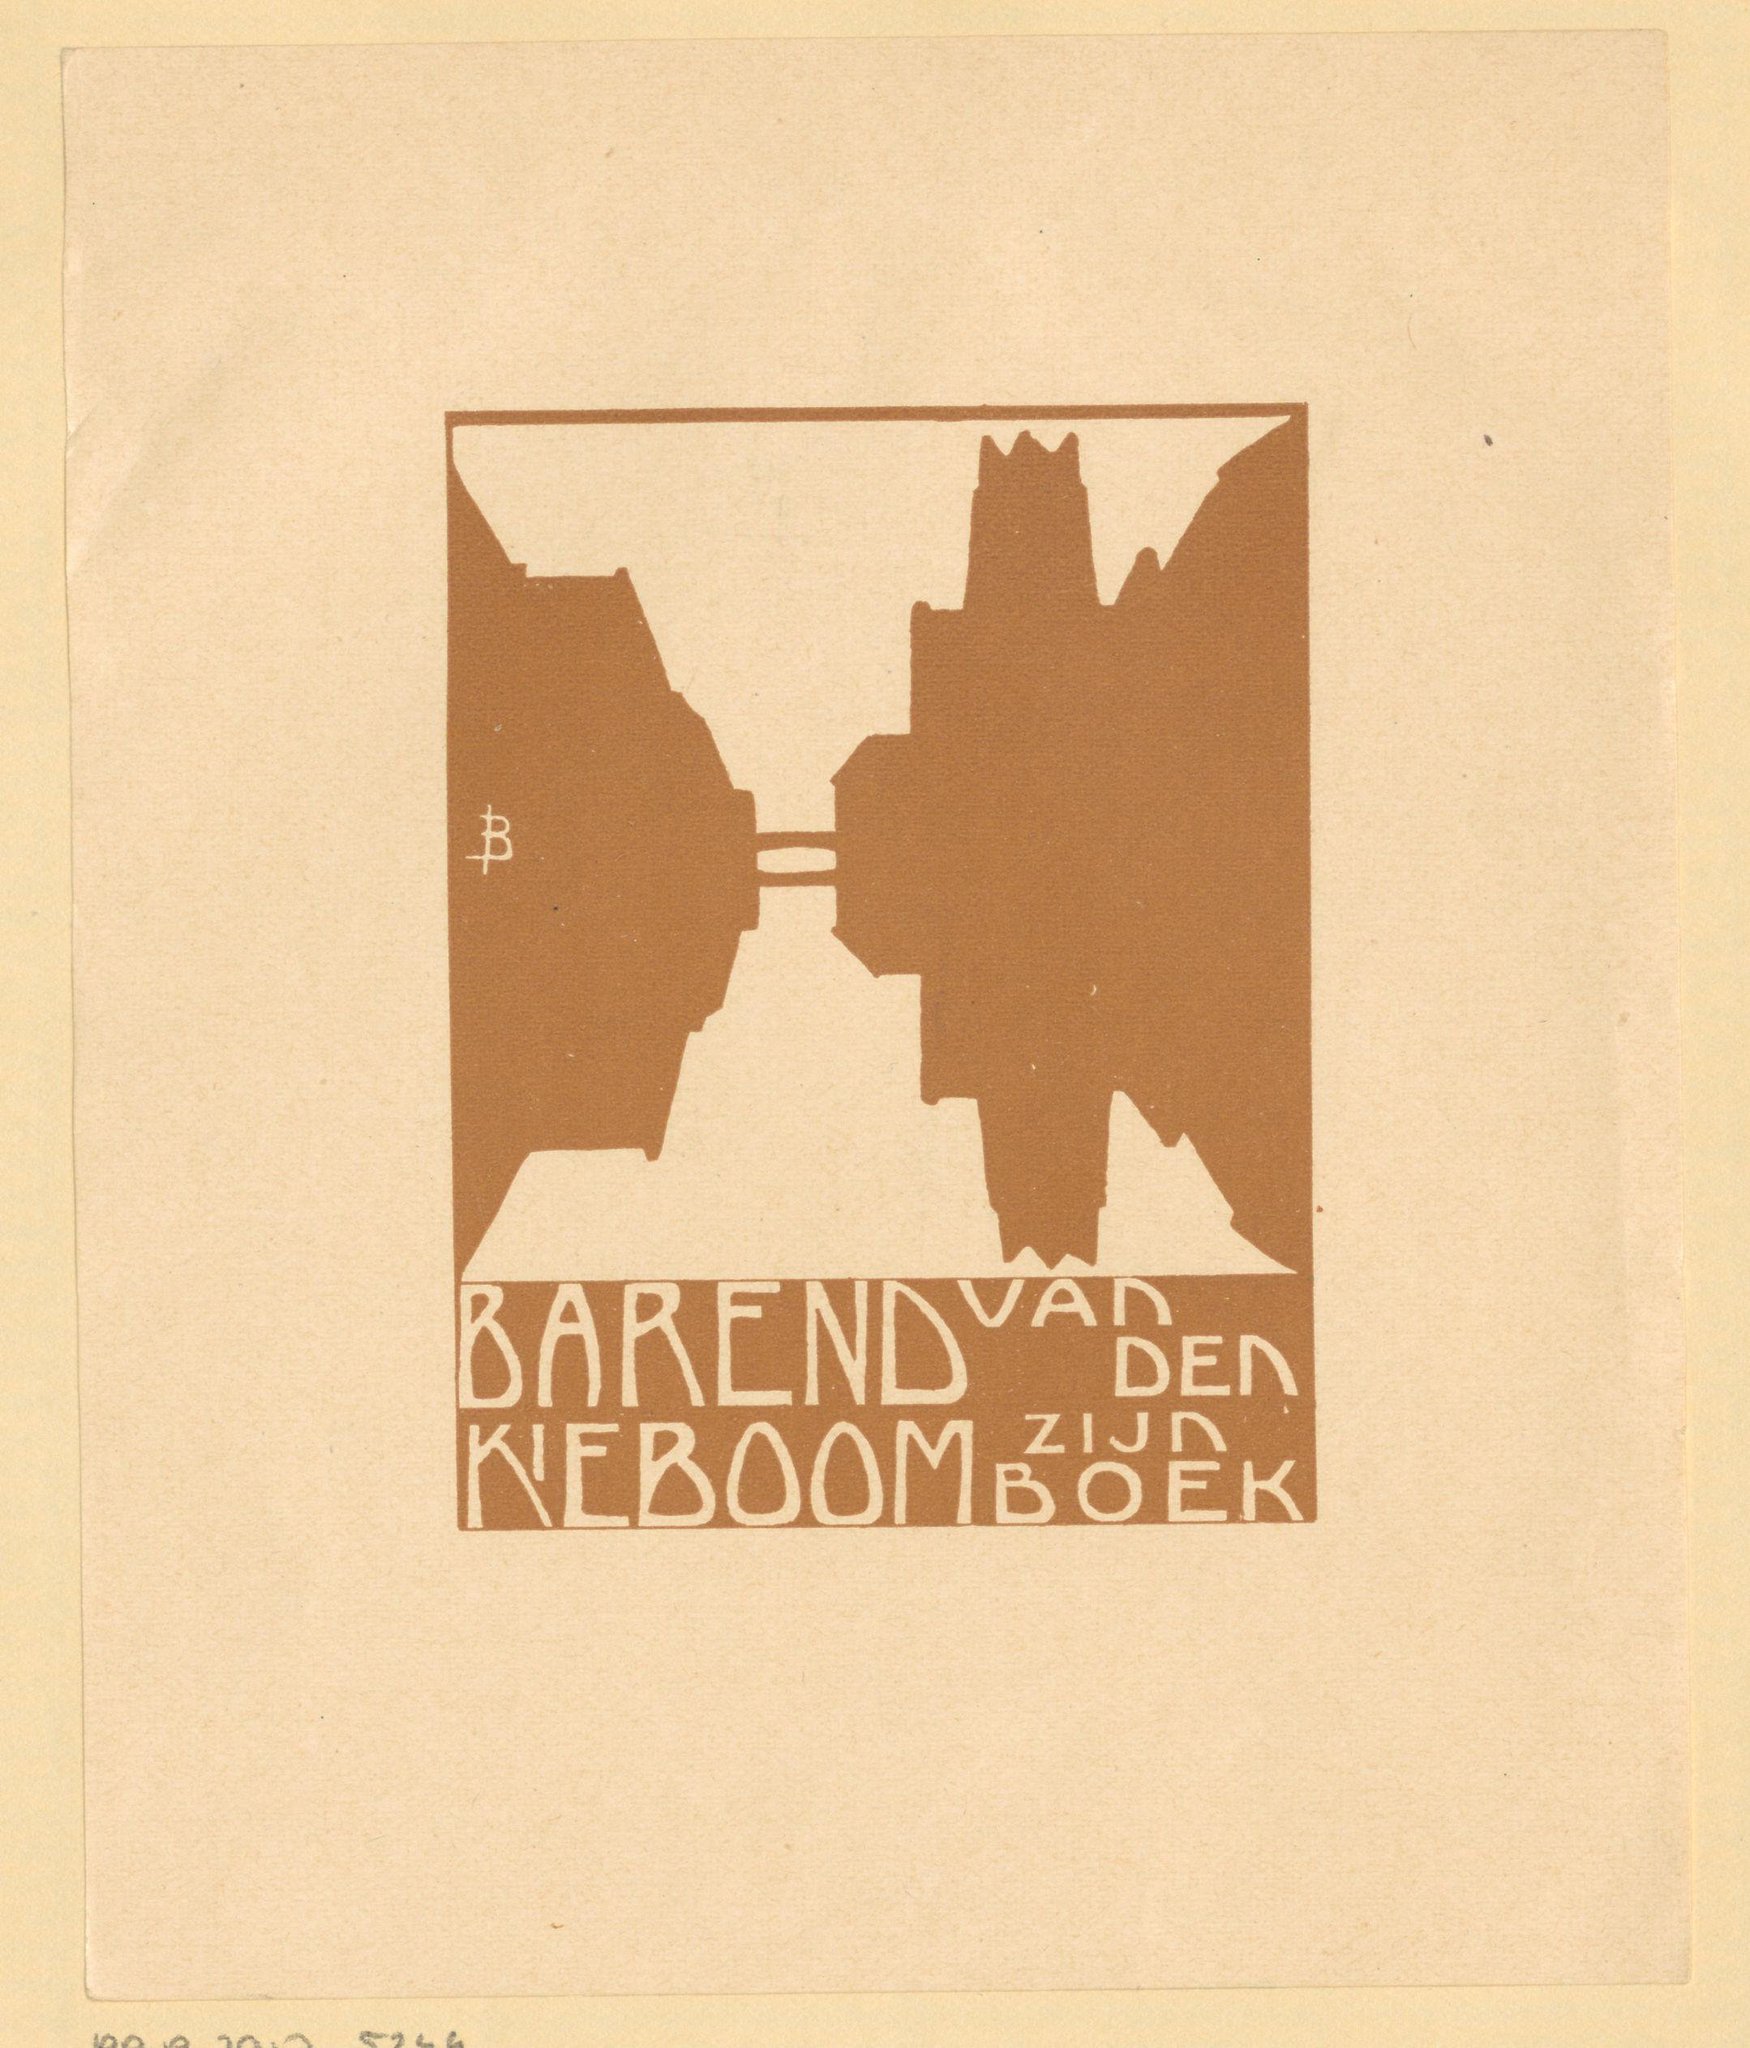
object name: bookplate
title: Ex libris van Barend van den Kieboom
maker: Anonymous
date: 1885-1922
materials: paper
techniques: printing block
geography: netherlands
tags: dordrecht, barend van den kieboom, canal, church (exterior)